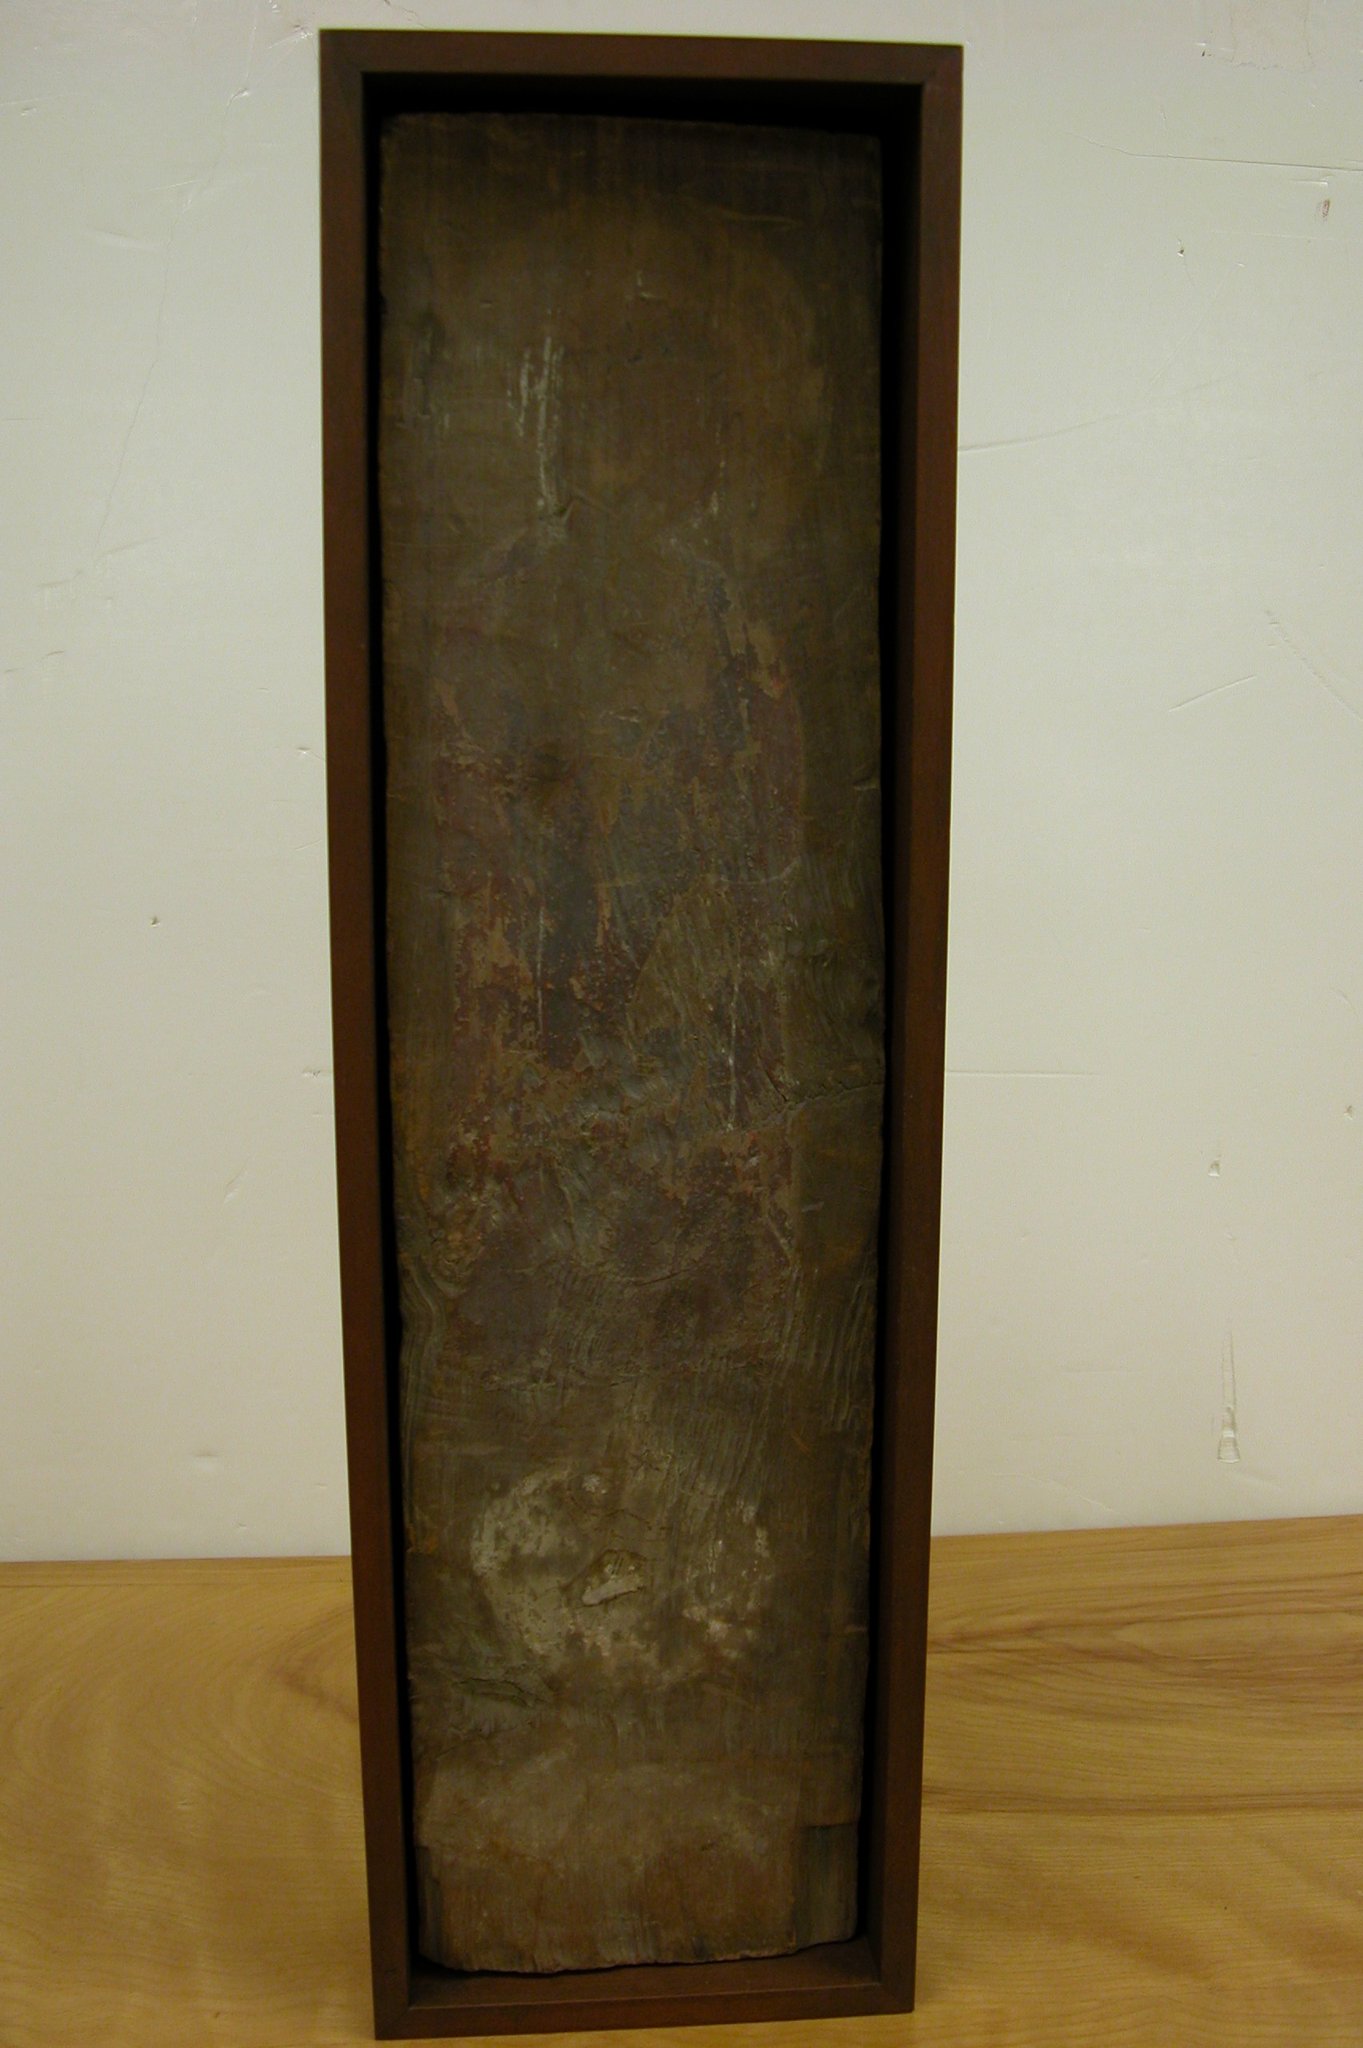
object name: wall painting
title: Standing Buddha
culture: central asian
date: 601-700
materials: pigment, wood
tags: buddhism,buddha